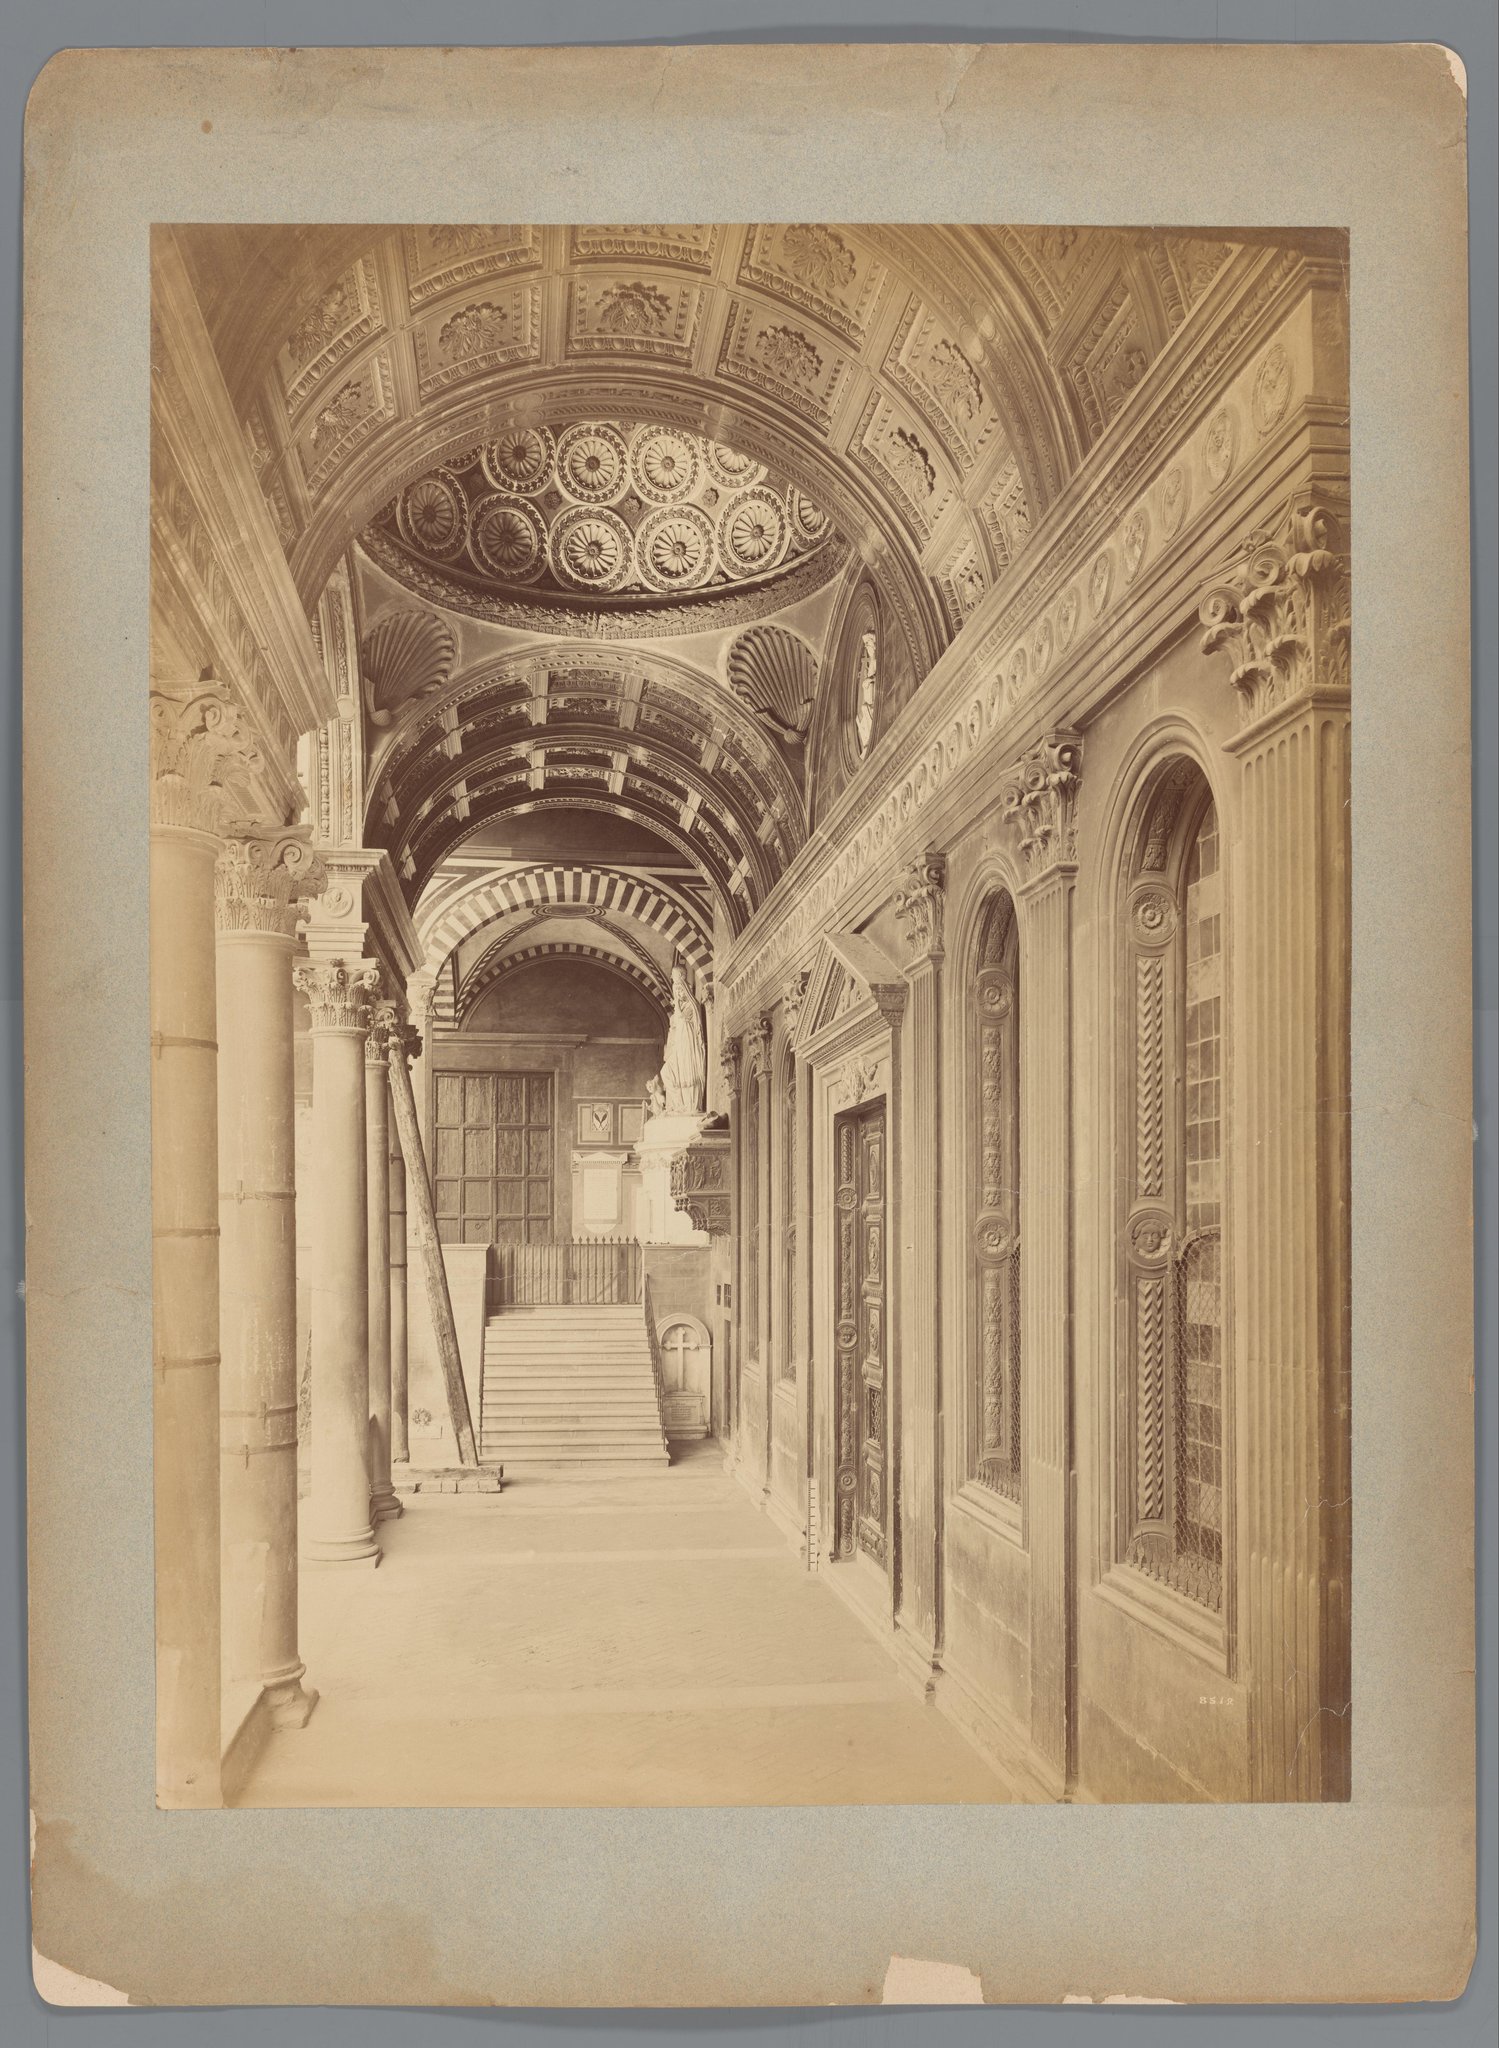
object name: photograph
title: Entree van de Pazzi kapel te Florence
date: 1880-1900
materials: cardboard, paper, photographic support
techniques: albumen print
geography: florence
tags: santa croce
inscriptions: : ‘FRATELLI ALINARI / FIRENZE’, : ‘8512’